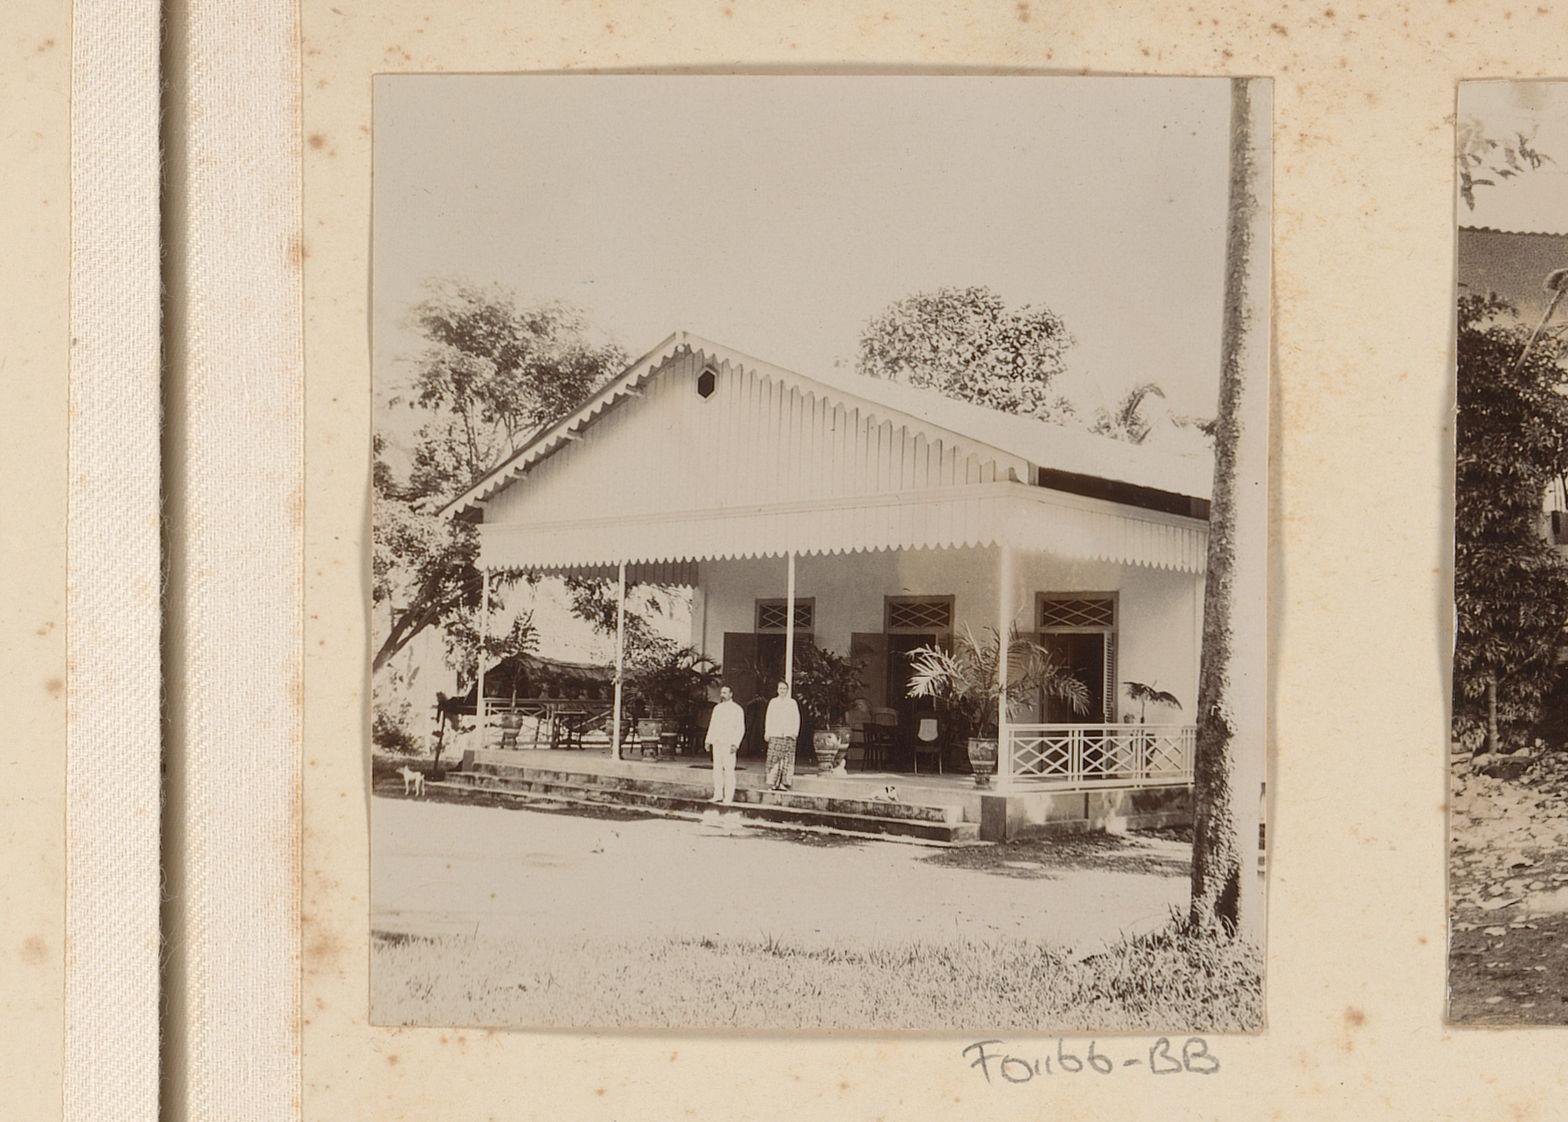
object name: album leaf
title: Man en vrouw voor een woning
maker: Anonymous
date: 1895-1910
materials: photographic support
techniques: daylight paper print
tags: historical persons, housing, dutch east indies, the